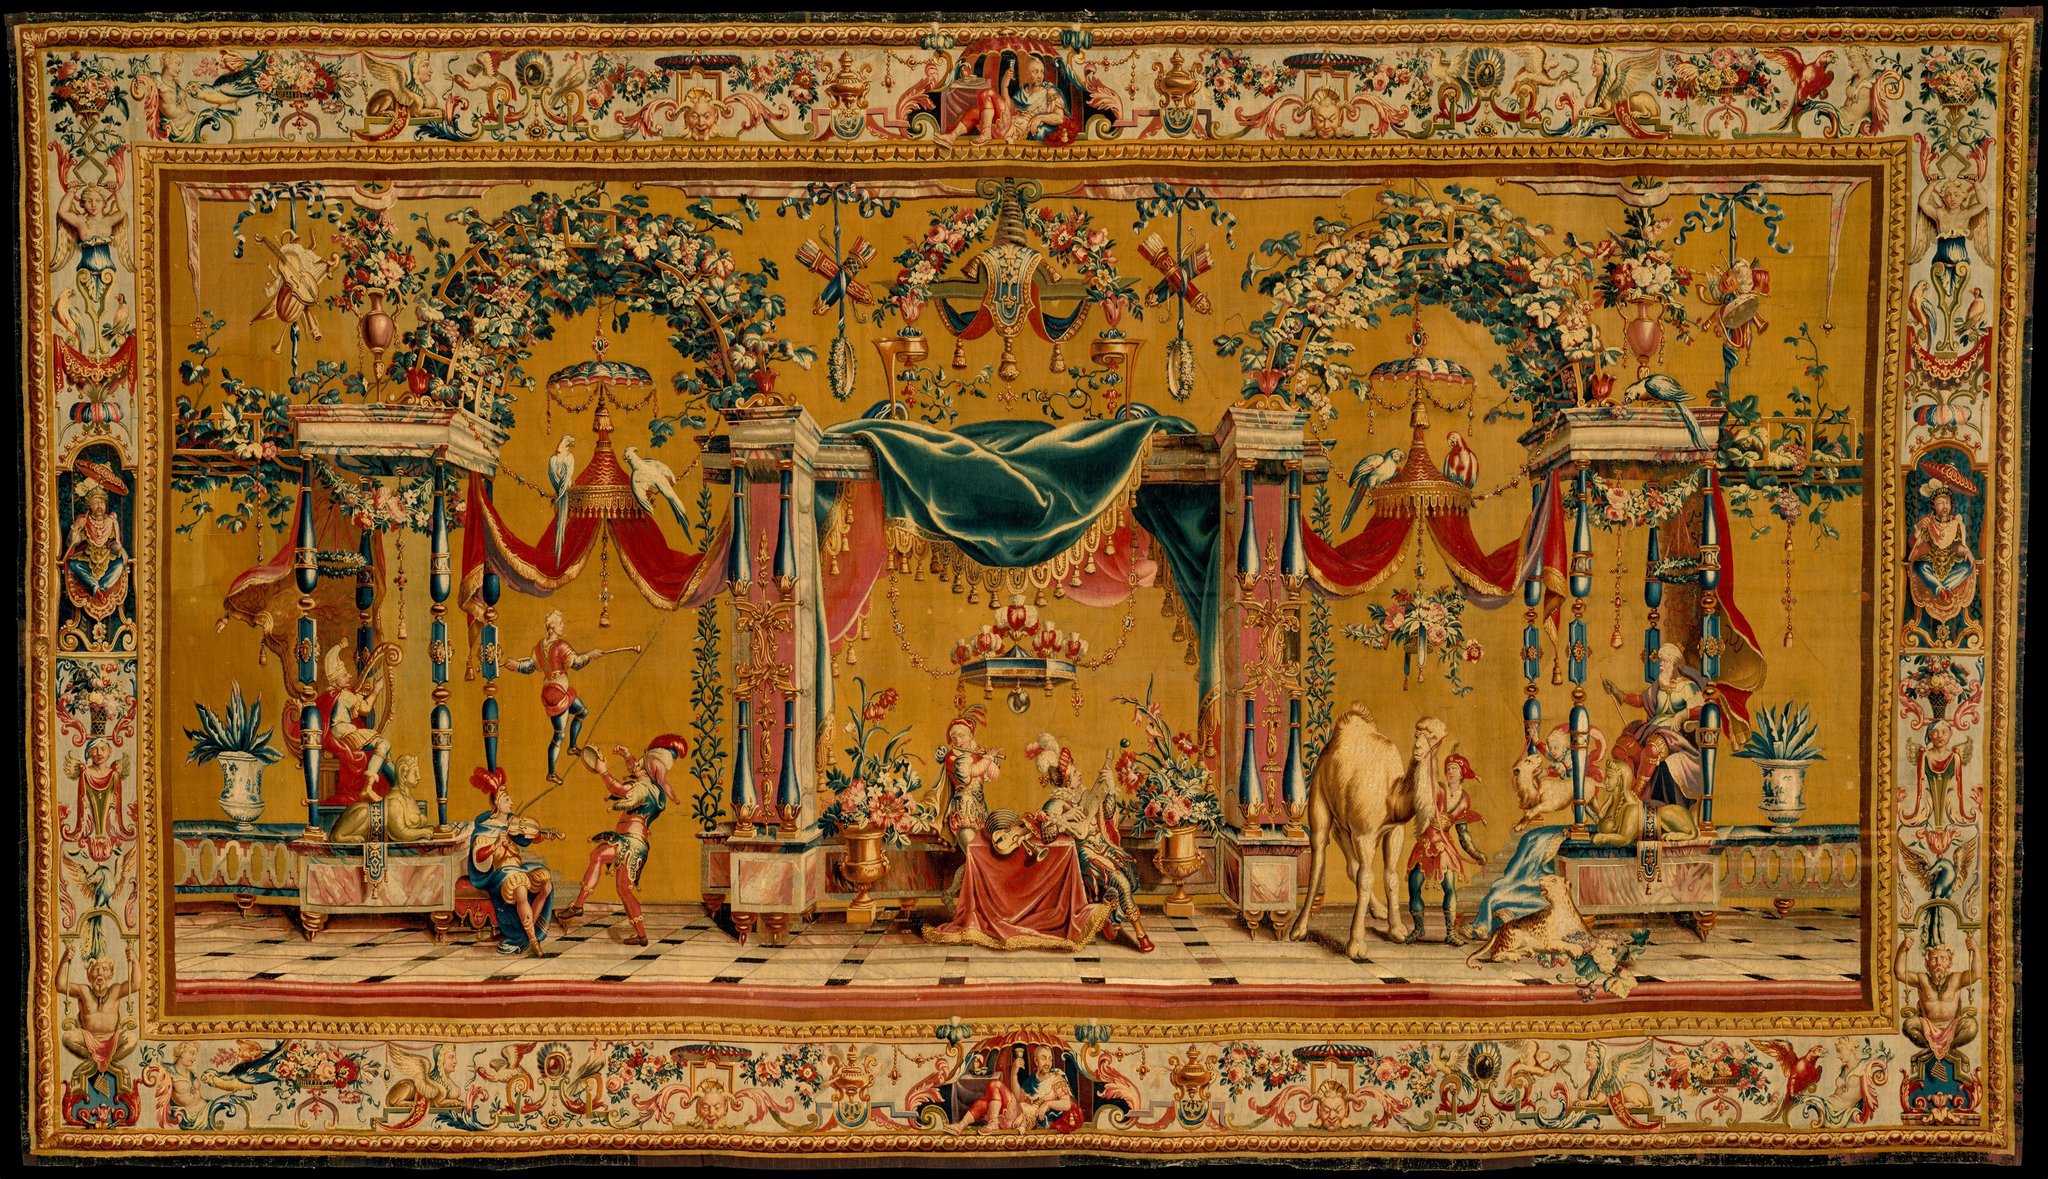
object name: tapestry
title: The Camel from a set of five Grotesques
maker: jean-baptiste monnoyer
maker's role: designer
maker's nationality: french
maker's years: 1636-1699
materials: silk, wool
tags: birds,fruit,men,women,dancing,sphinx,camels,leopards,flowers,acrobats